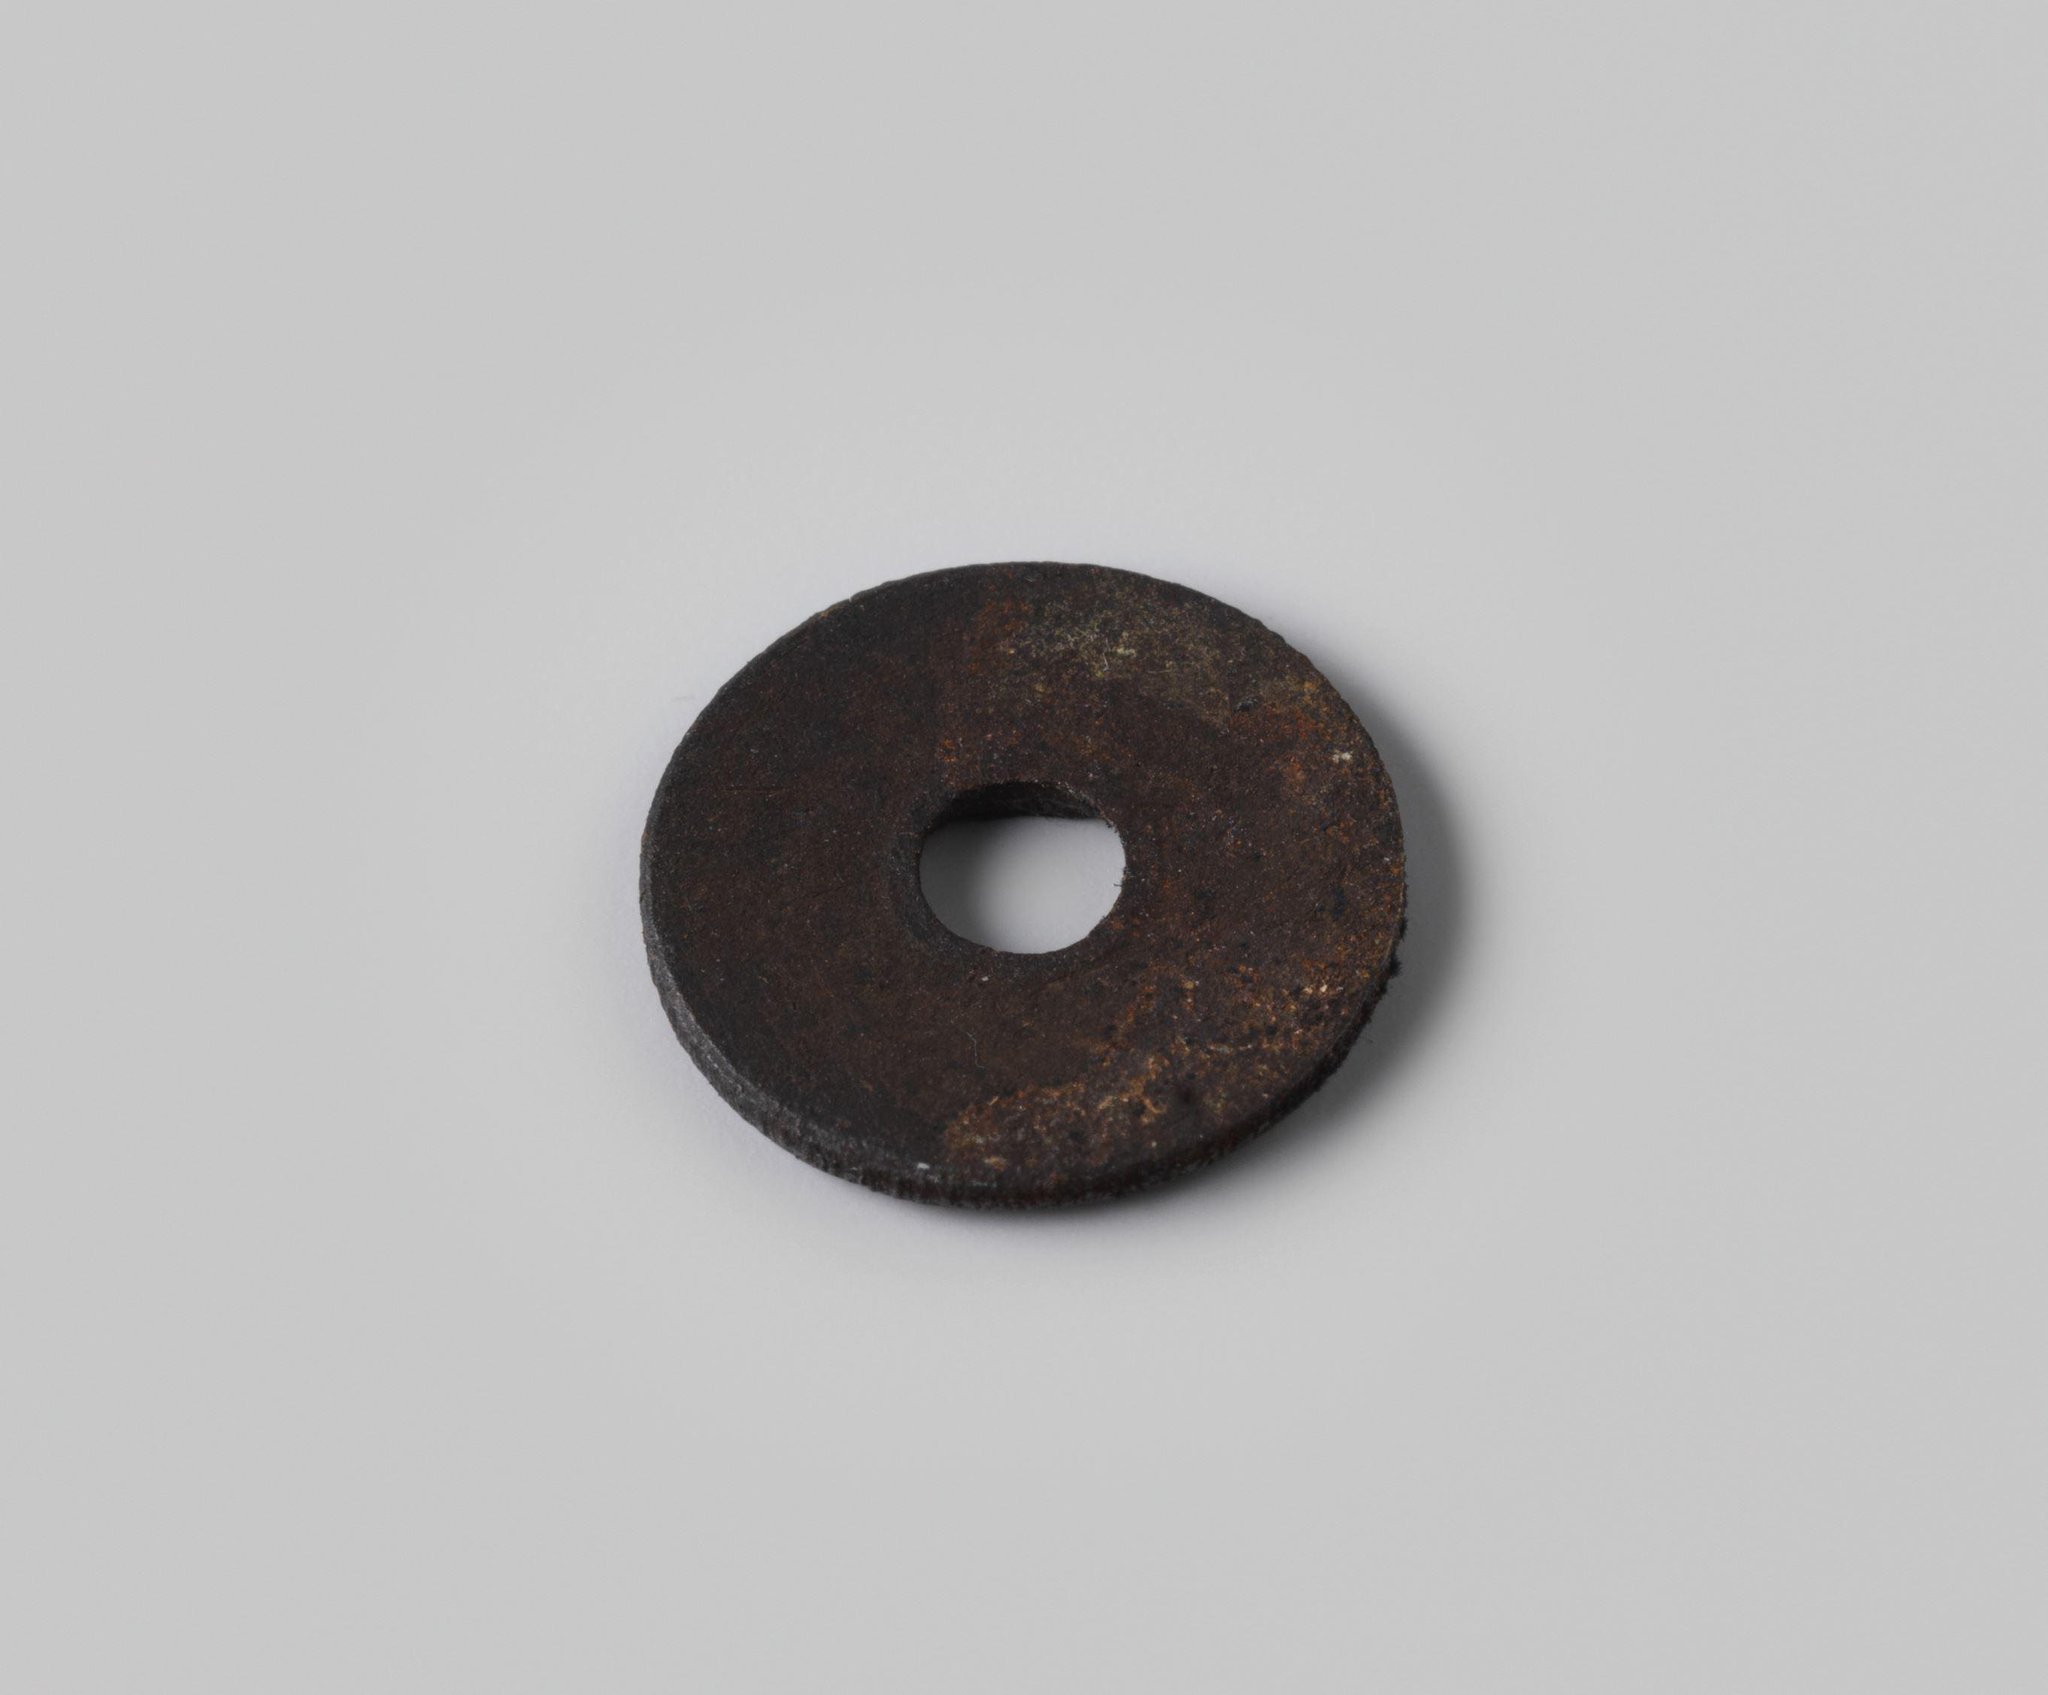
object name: sluitring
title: Sluitring uit het wrak van de Oost-Indiëvaarder Hollandia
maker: Anonymous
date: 1700-1743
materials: copper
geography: netherlands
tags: verenigde oostindische compagnie, hollandia (schip), annet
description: Varied parts or fragments, washers; circular, flat, circular central hole.